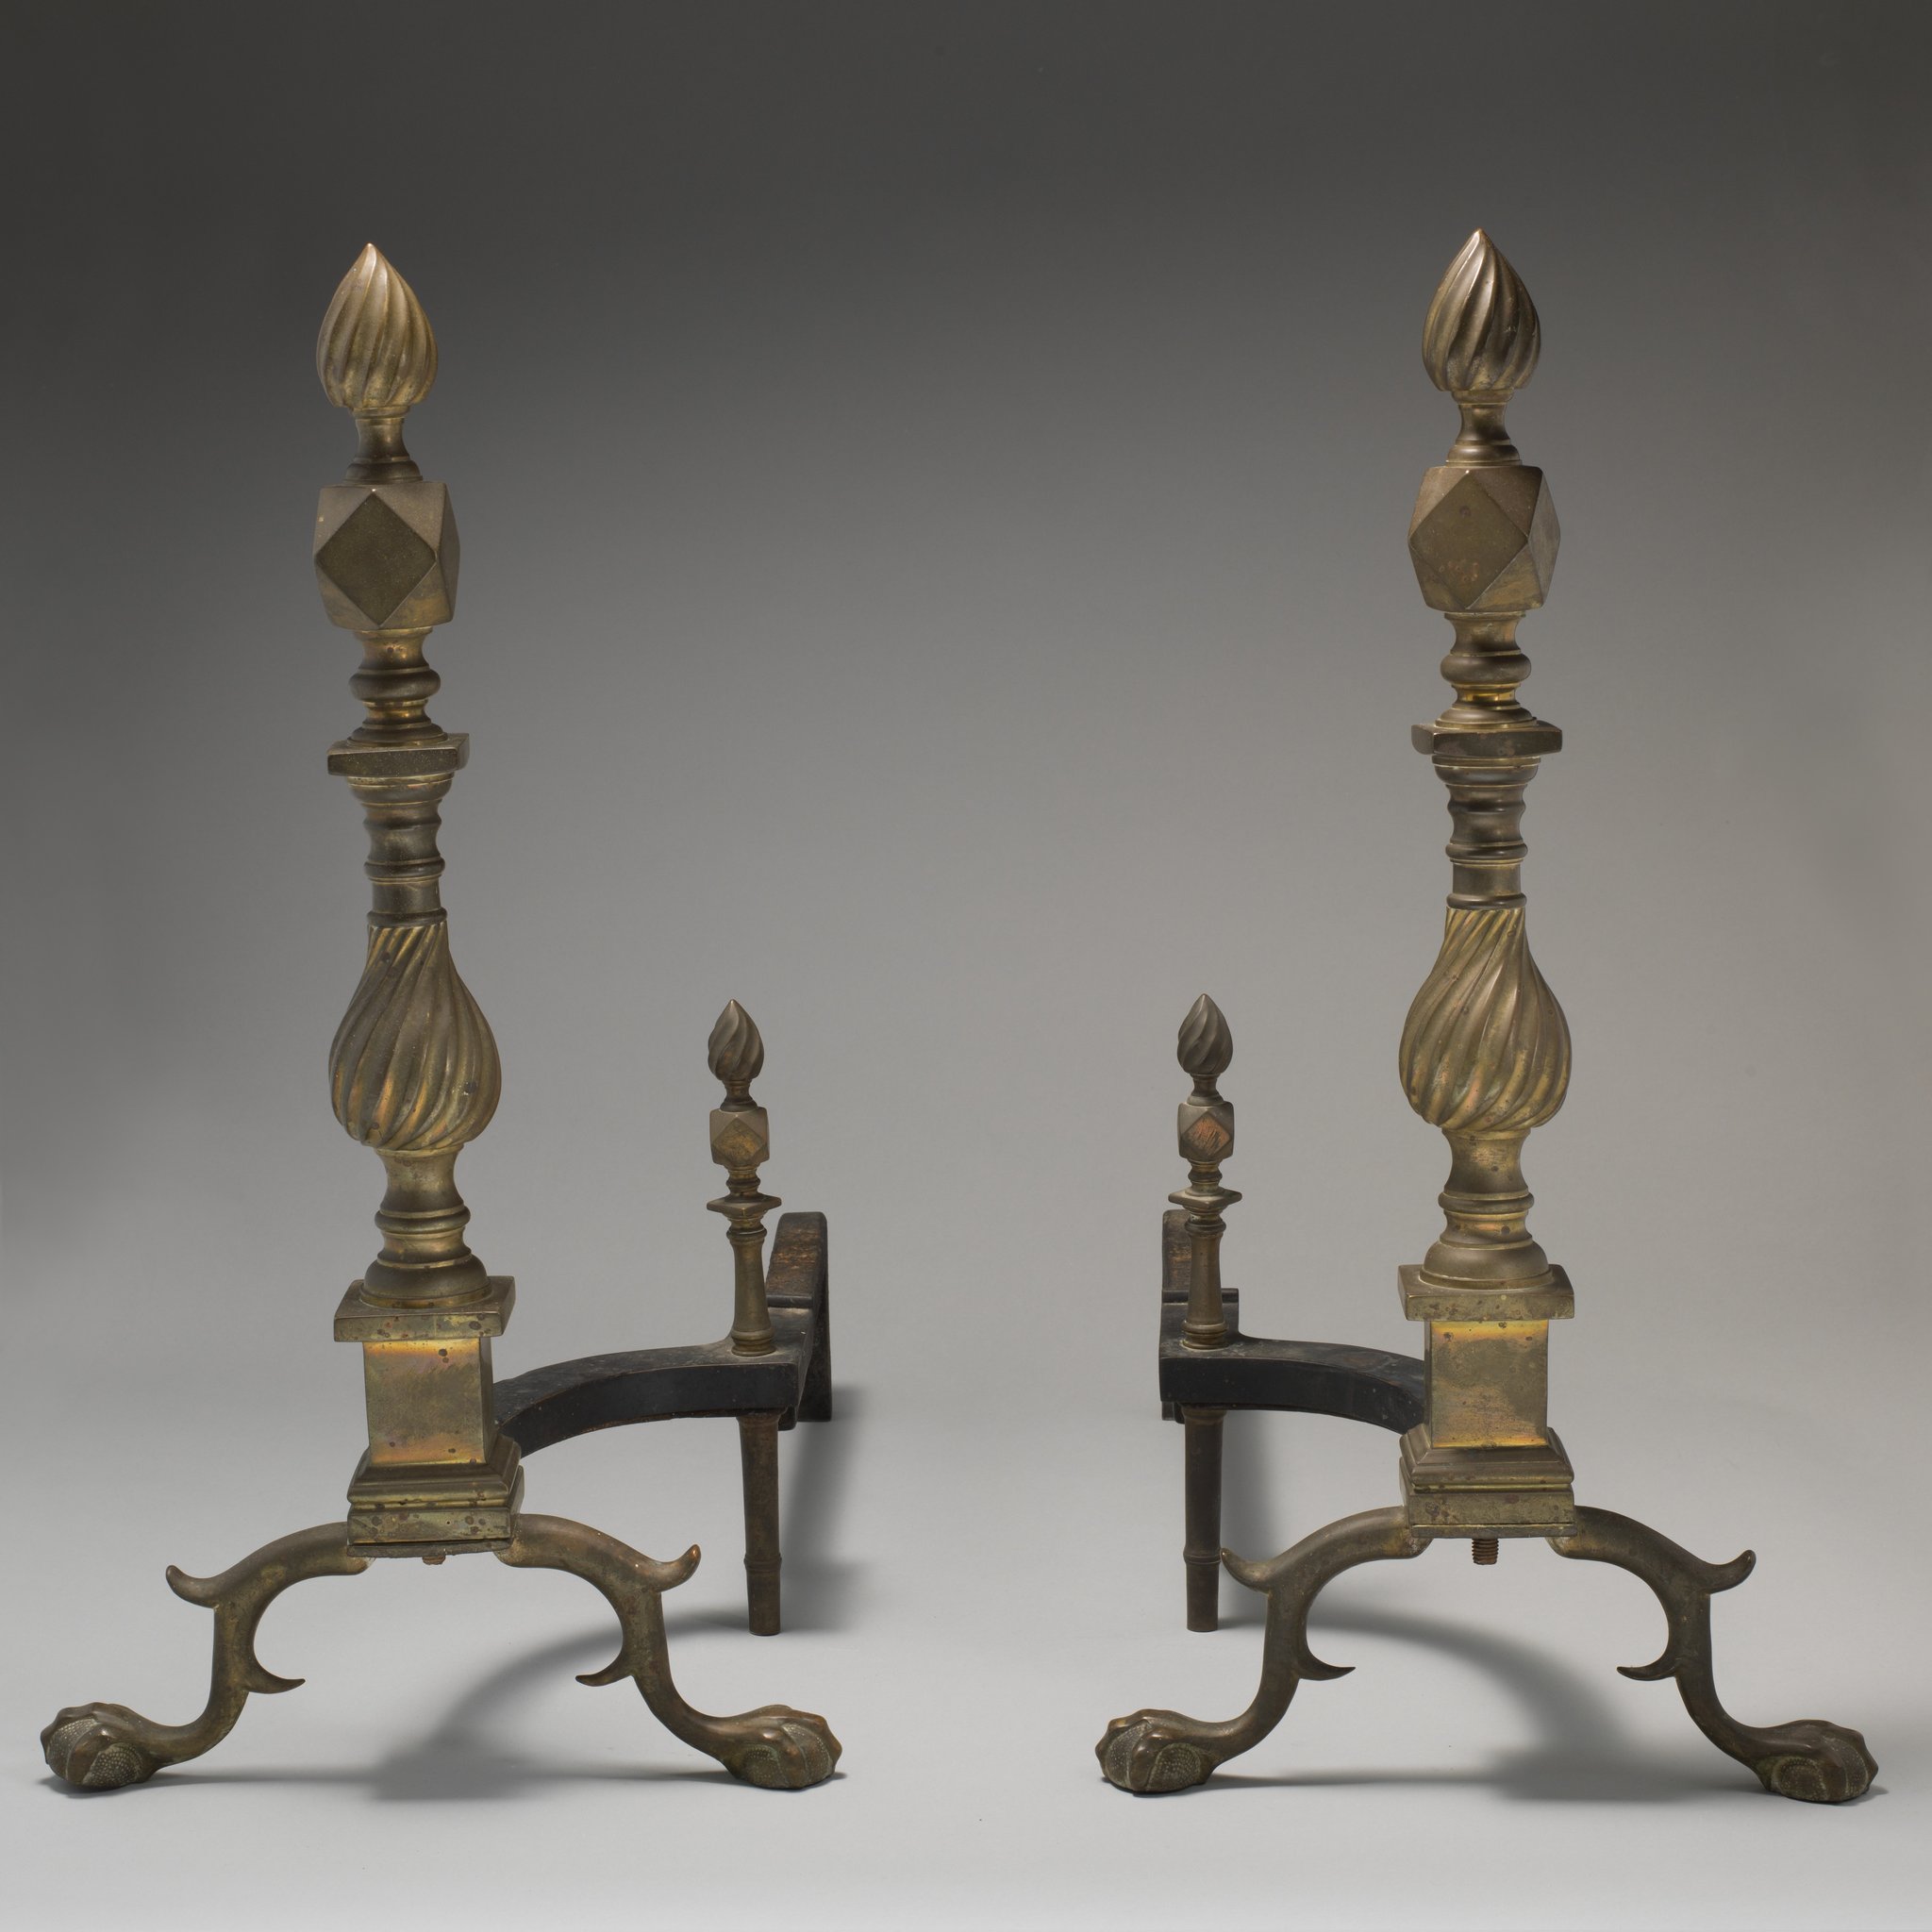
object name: andiron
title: Pair of andirons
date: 1701-1800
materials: brass, iron